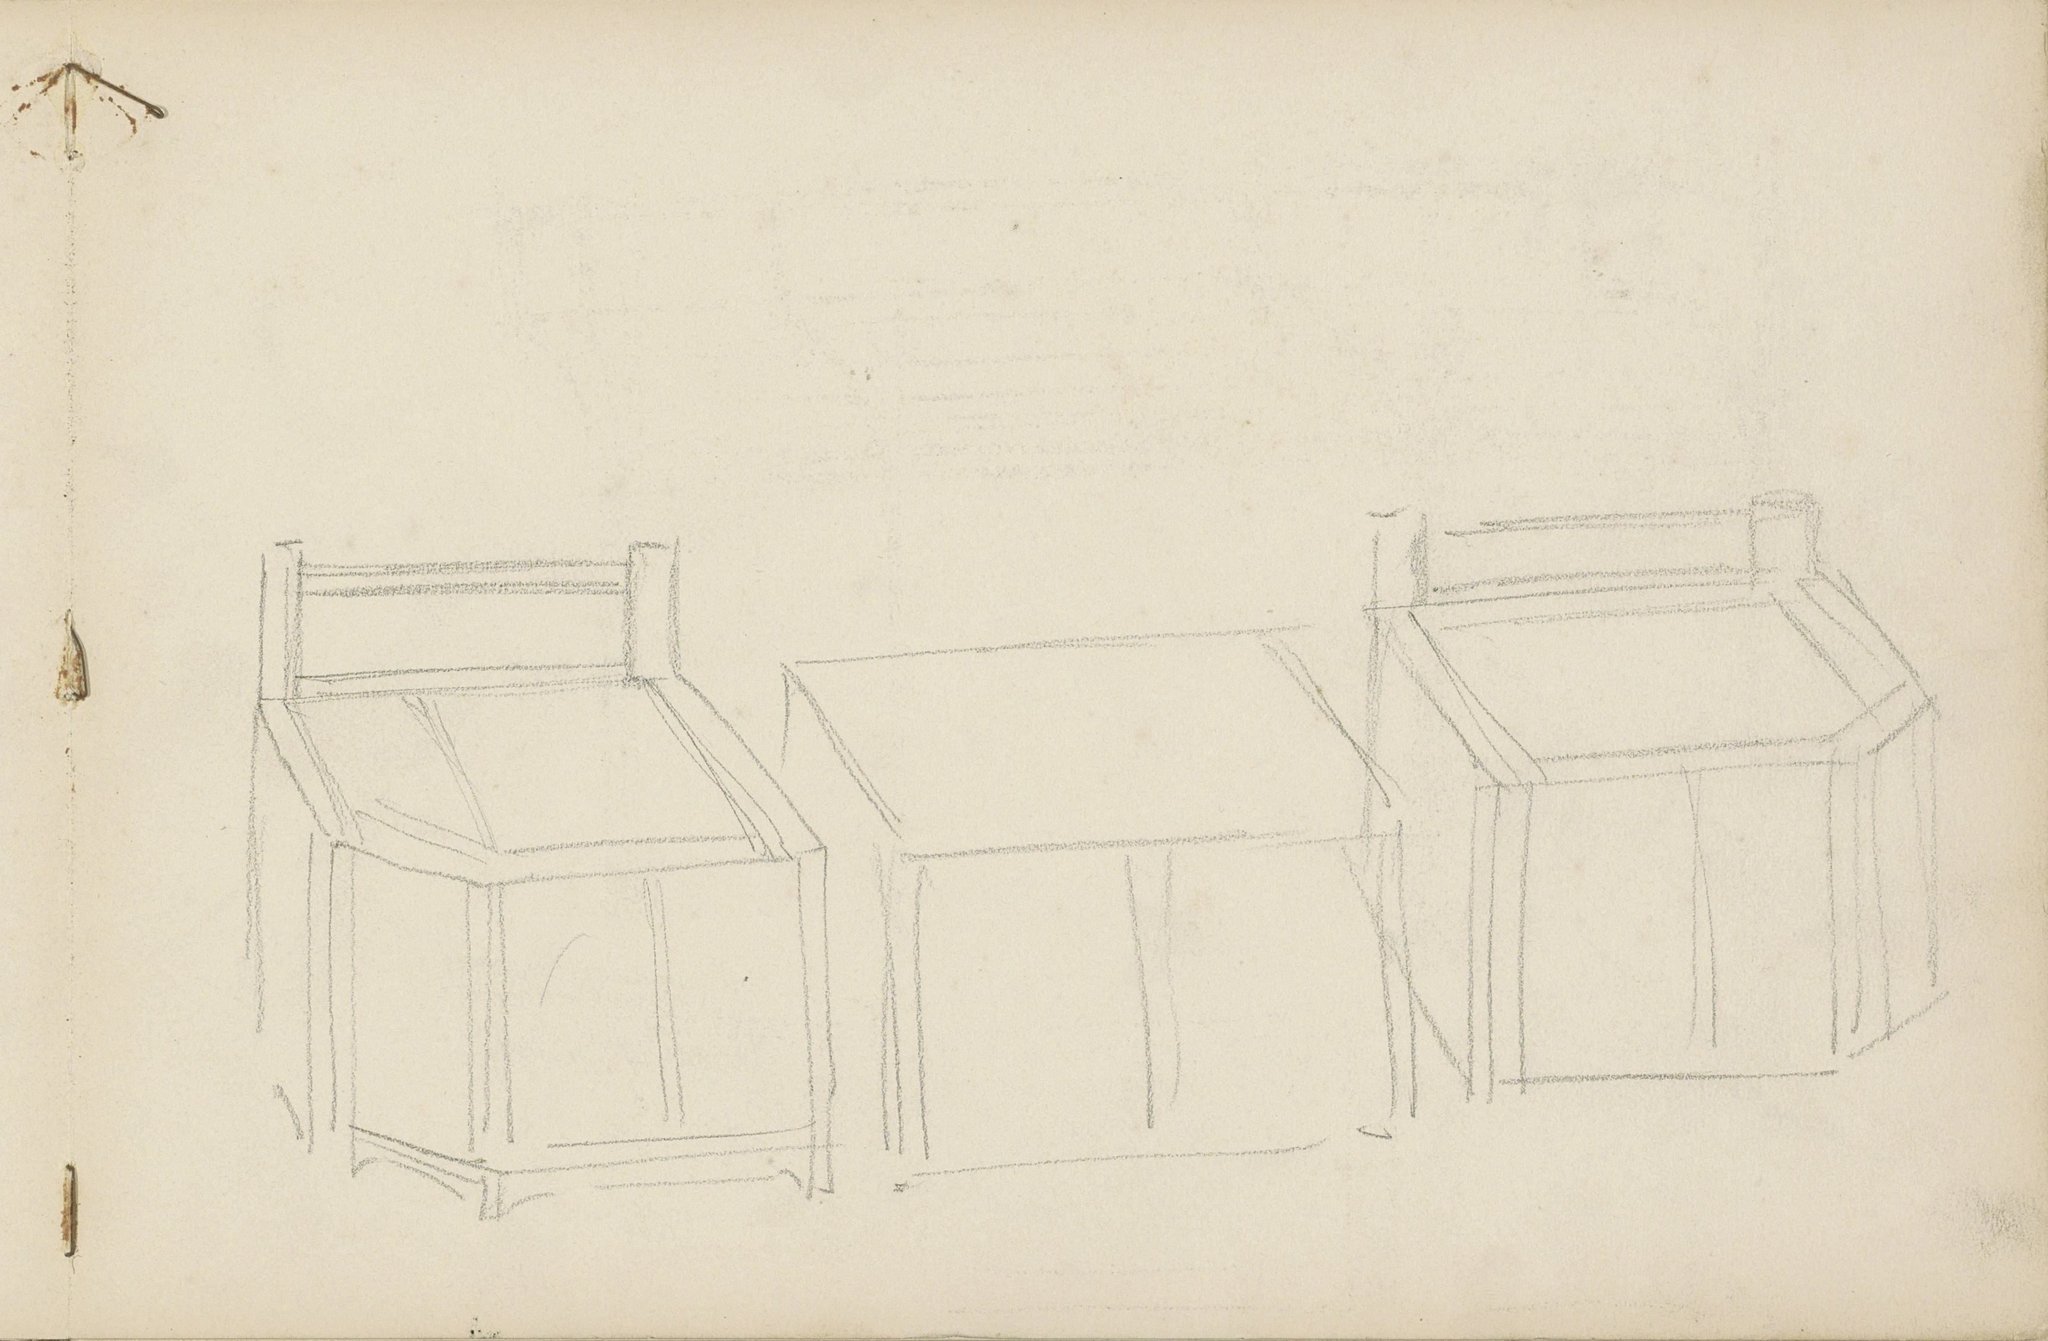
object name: sketchbook leaf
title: Ontwerpen voor meubels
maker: carel adolph lion cachet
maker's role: draughtsman, print maker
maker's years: 1864-1945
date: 1908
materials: paper, pencil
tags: furniture and household effects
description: Blad 2 recto uit een schetsboek met 25 bladen.